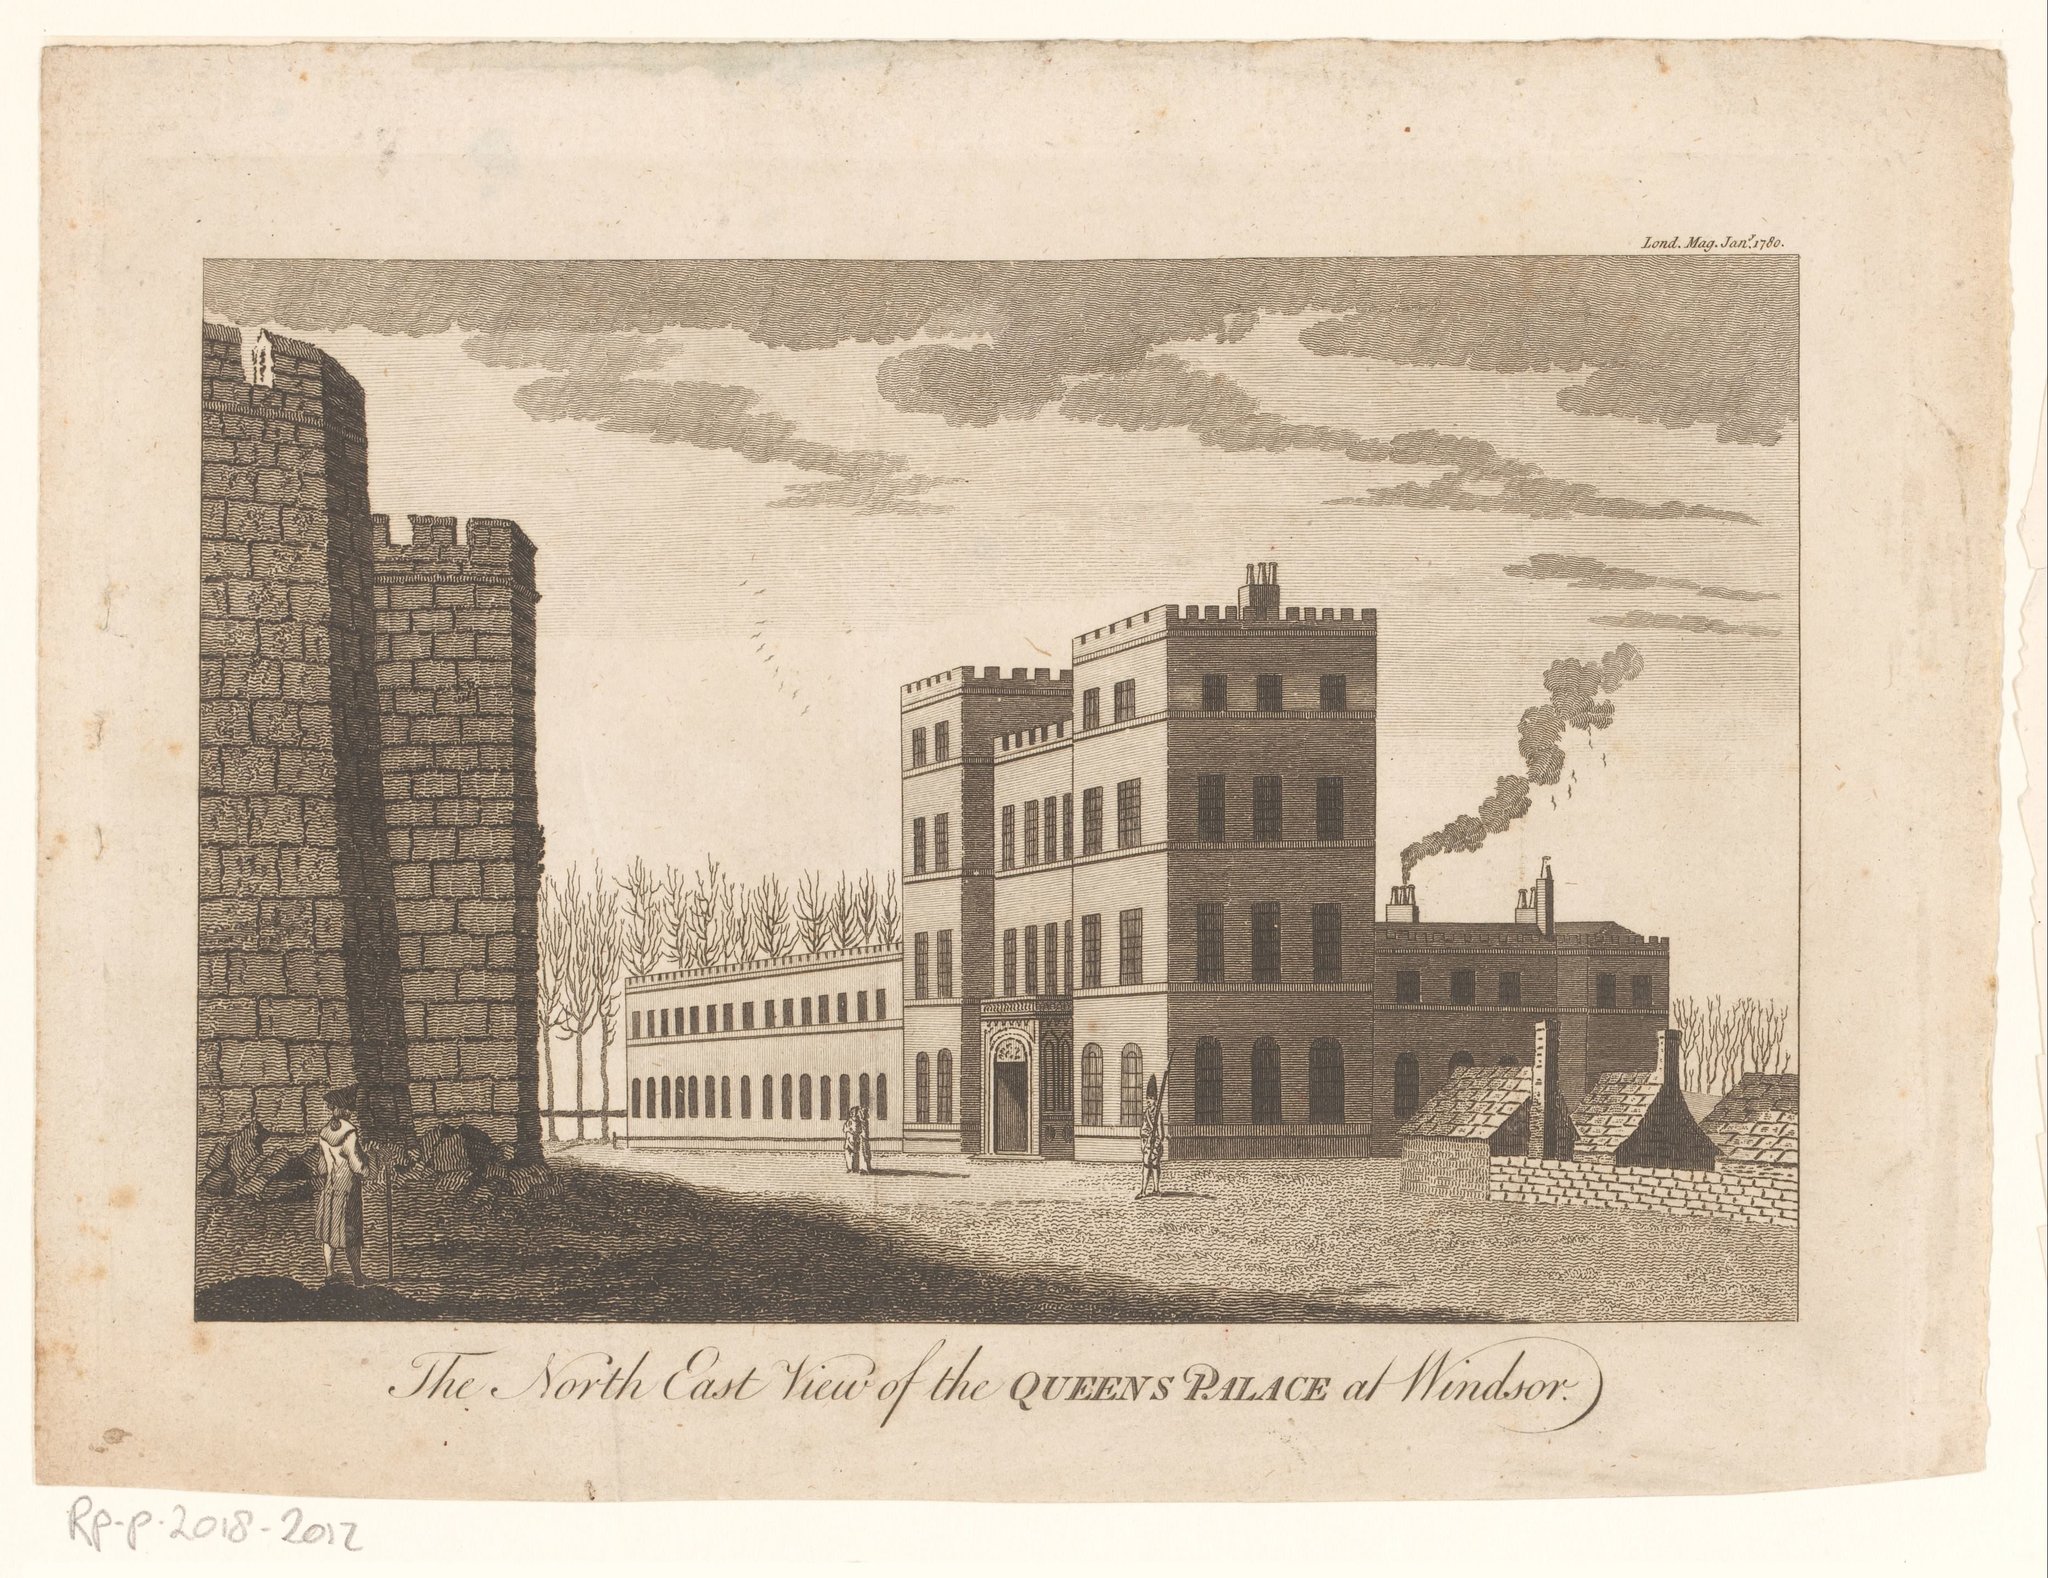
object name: print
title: The north east view of the queens palace at Windsor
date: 1780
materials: paper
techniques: etching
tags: castle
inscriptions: collector's mark: Lugt 2228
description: Prent gebruikt in: The London Magazine or Gentlemans monthly intelligencer. Londen: R. Baldwin, 1780.